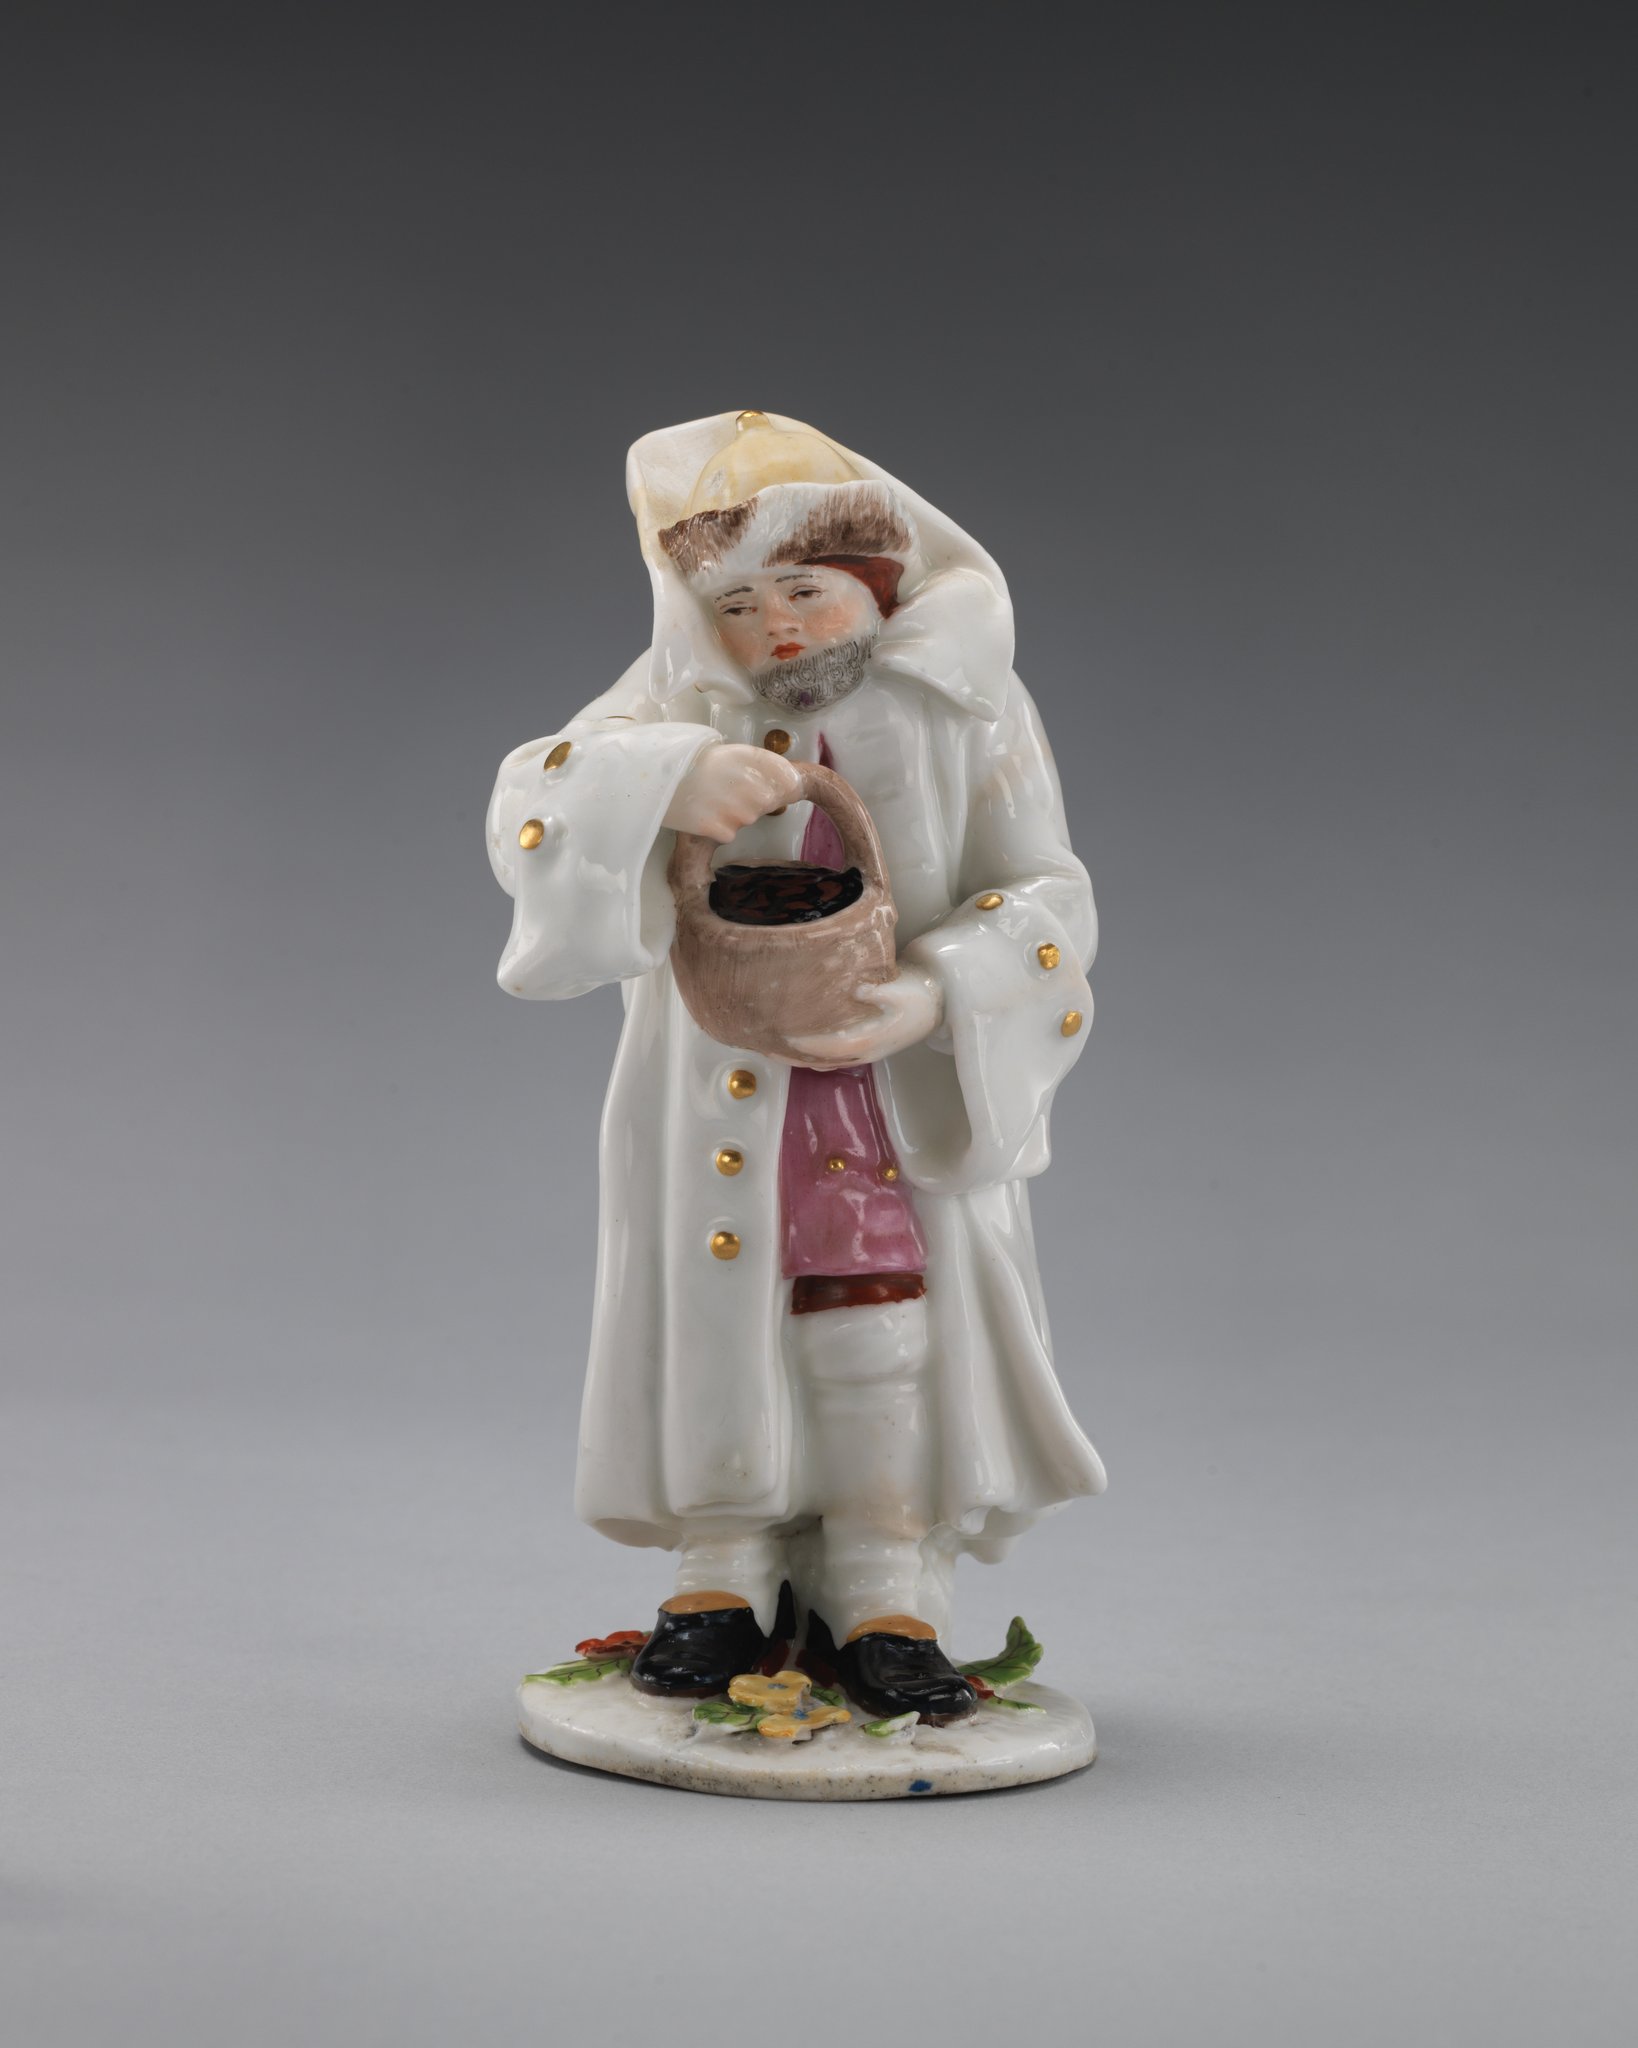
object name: figure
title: Four Seasons (Winter)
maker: chelsea porcelain manufactory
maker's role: factory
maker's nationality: british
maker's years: 1744-1784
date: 1753-1755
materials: soft paste porcelain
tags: men